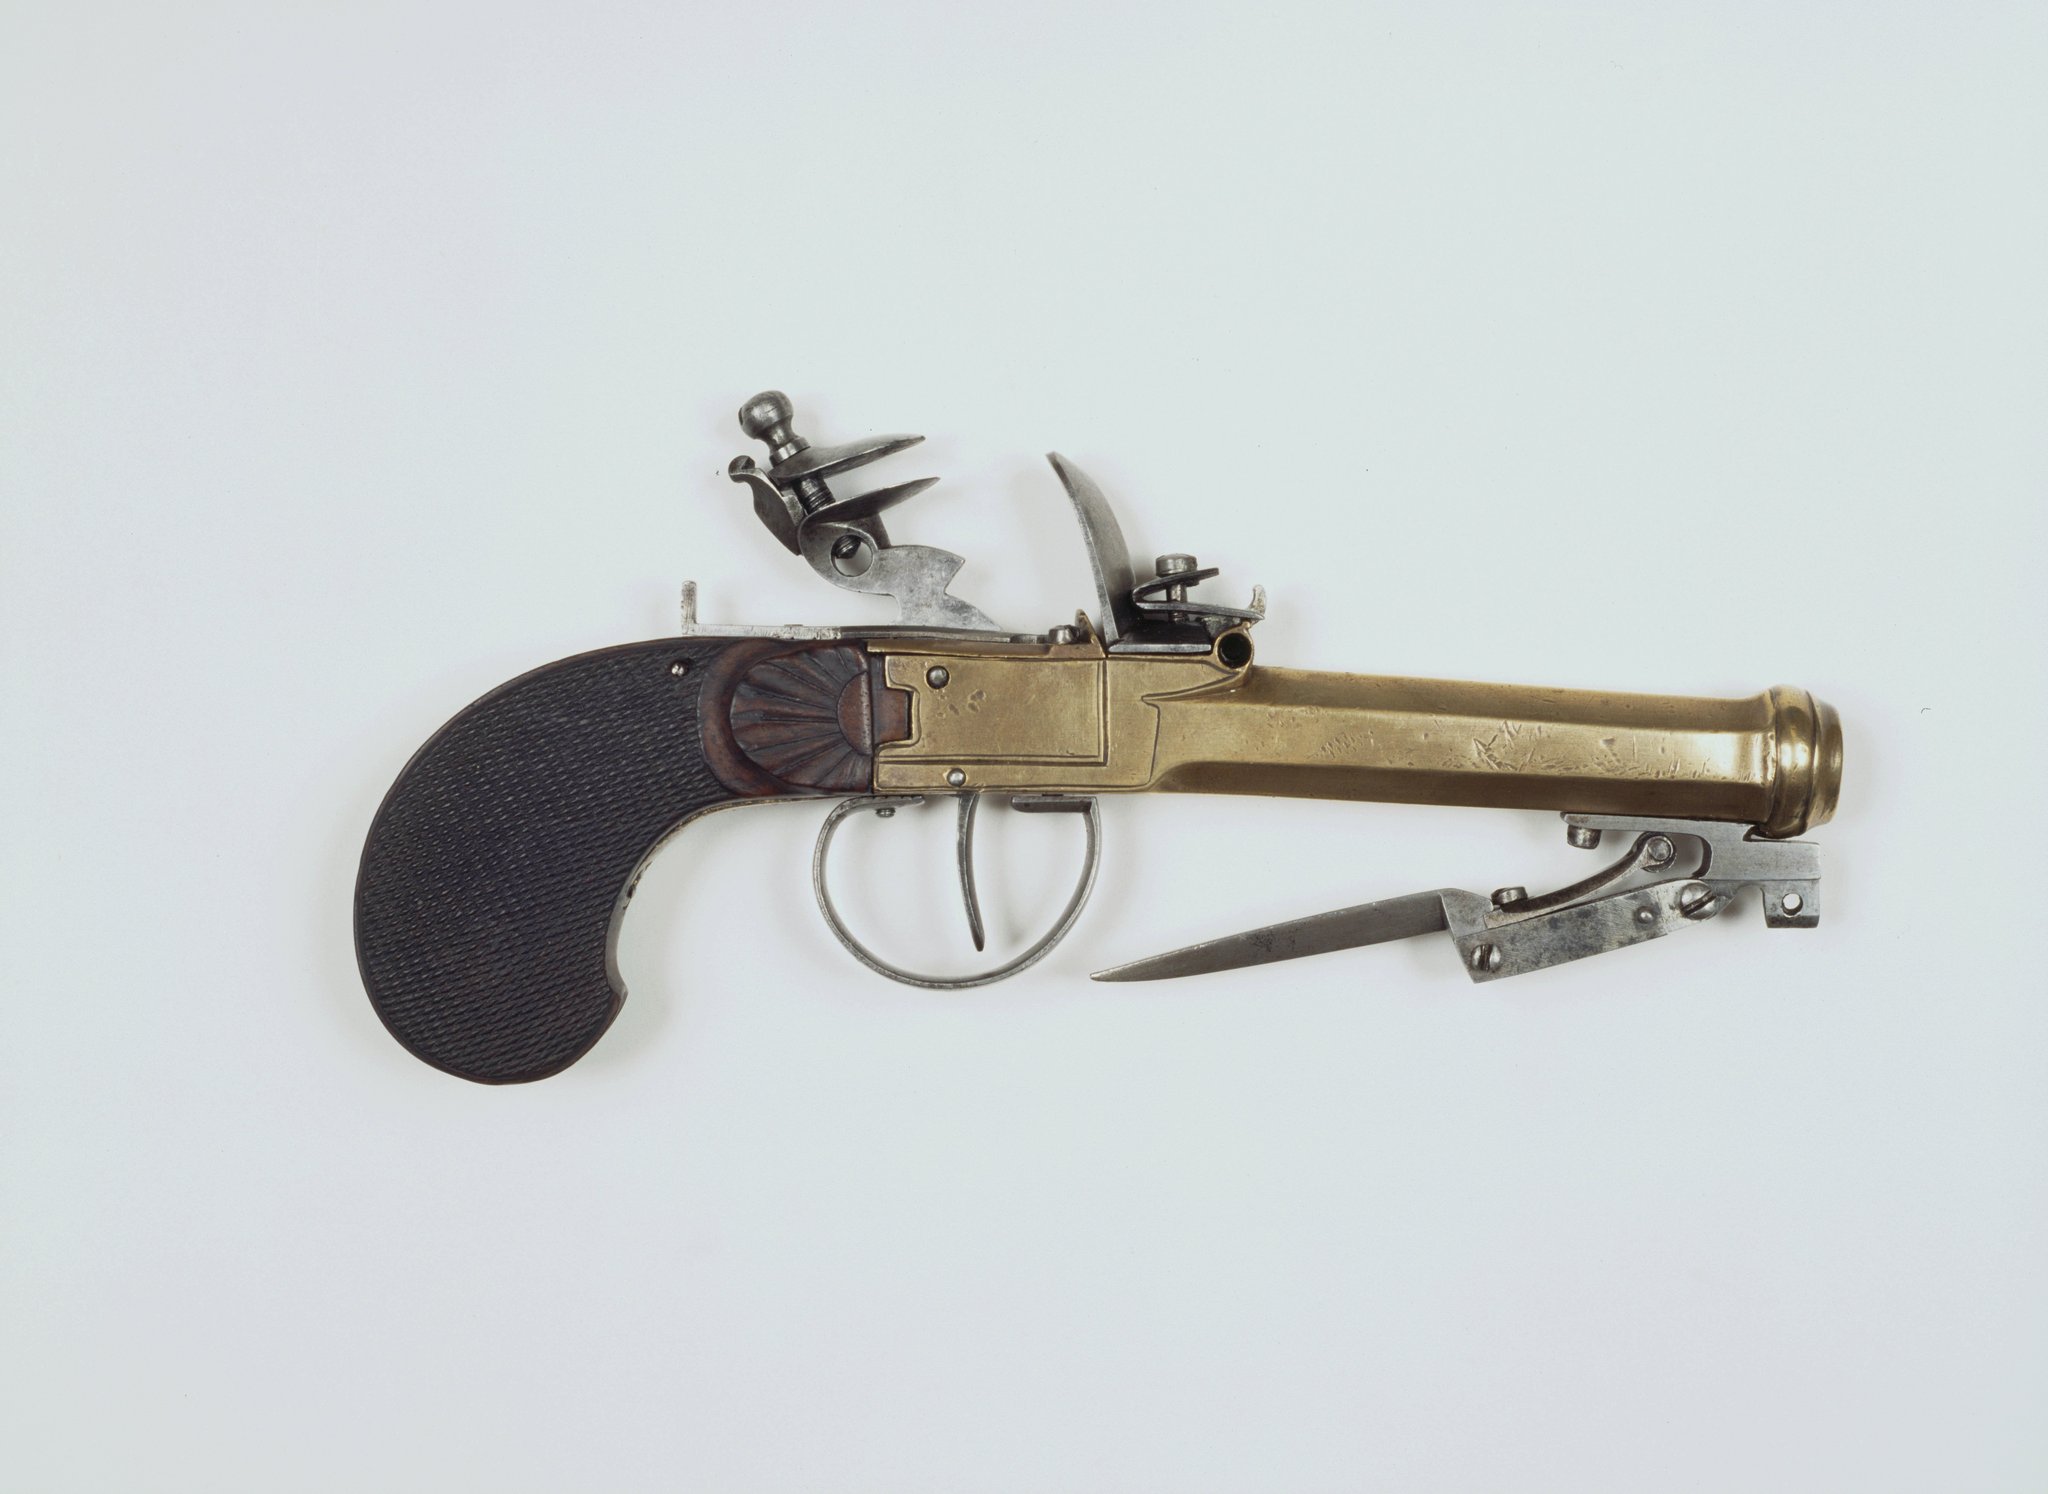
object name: flintlock pistol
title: Vuursteenpistool met bajonet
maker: Anonymous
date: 1800-1825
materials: bronze, iron, wood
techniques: cutting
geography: liège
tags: netherlands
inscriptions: mark: ‘E // L G // *’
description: Vuursteenpistool, met uitspringende ijzeren bajonet, een gladde, achthoekige loop waarop staat gegraveerd 'L.E.G.'. Platte slotplaat van brons met ijzeren haan en vuurstaal. De lade is van hout met een ingekerfde schelpmotief. Kolf is van hout en heeft een geribbelde greep. Over de gehele lengte van de kolfhals twee dunne ingekerfde decoratielijnen.